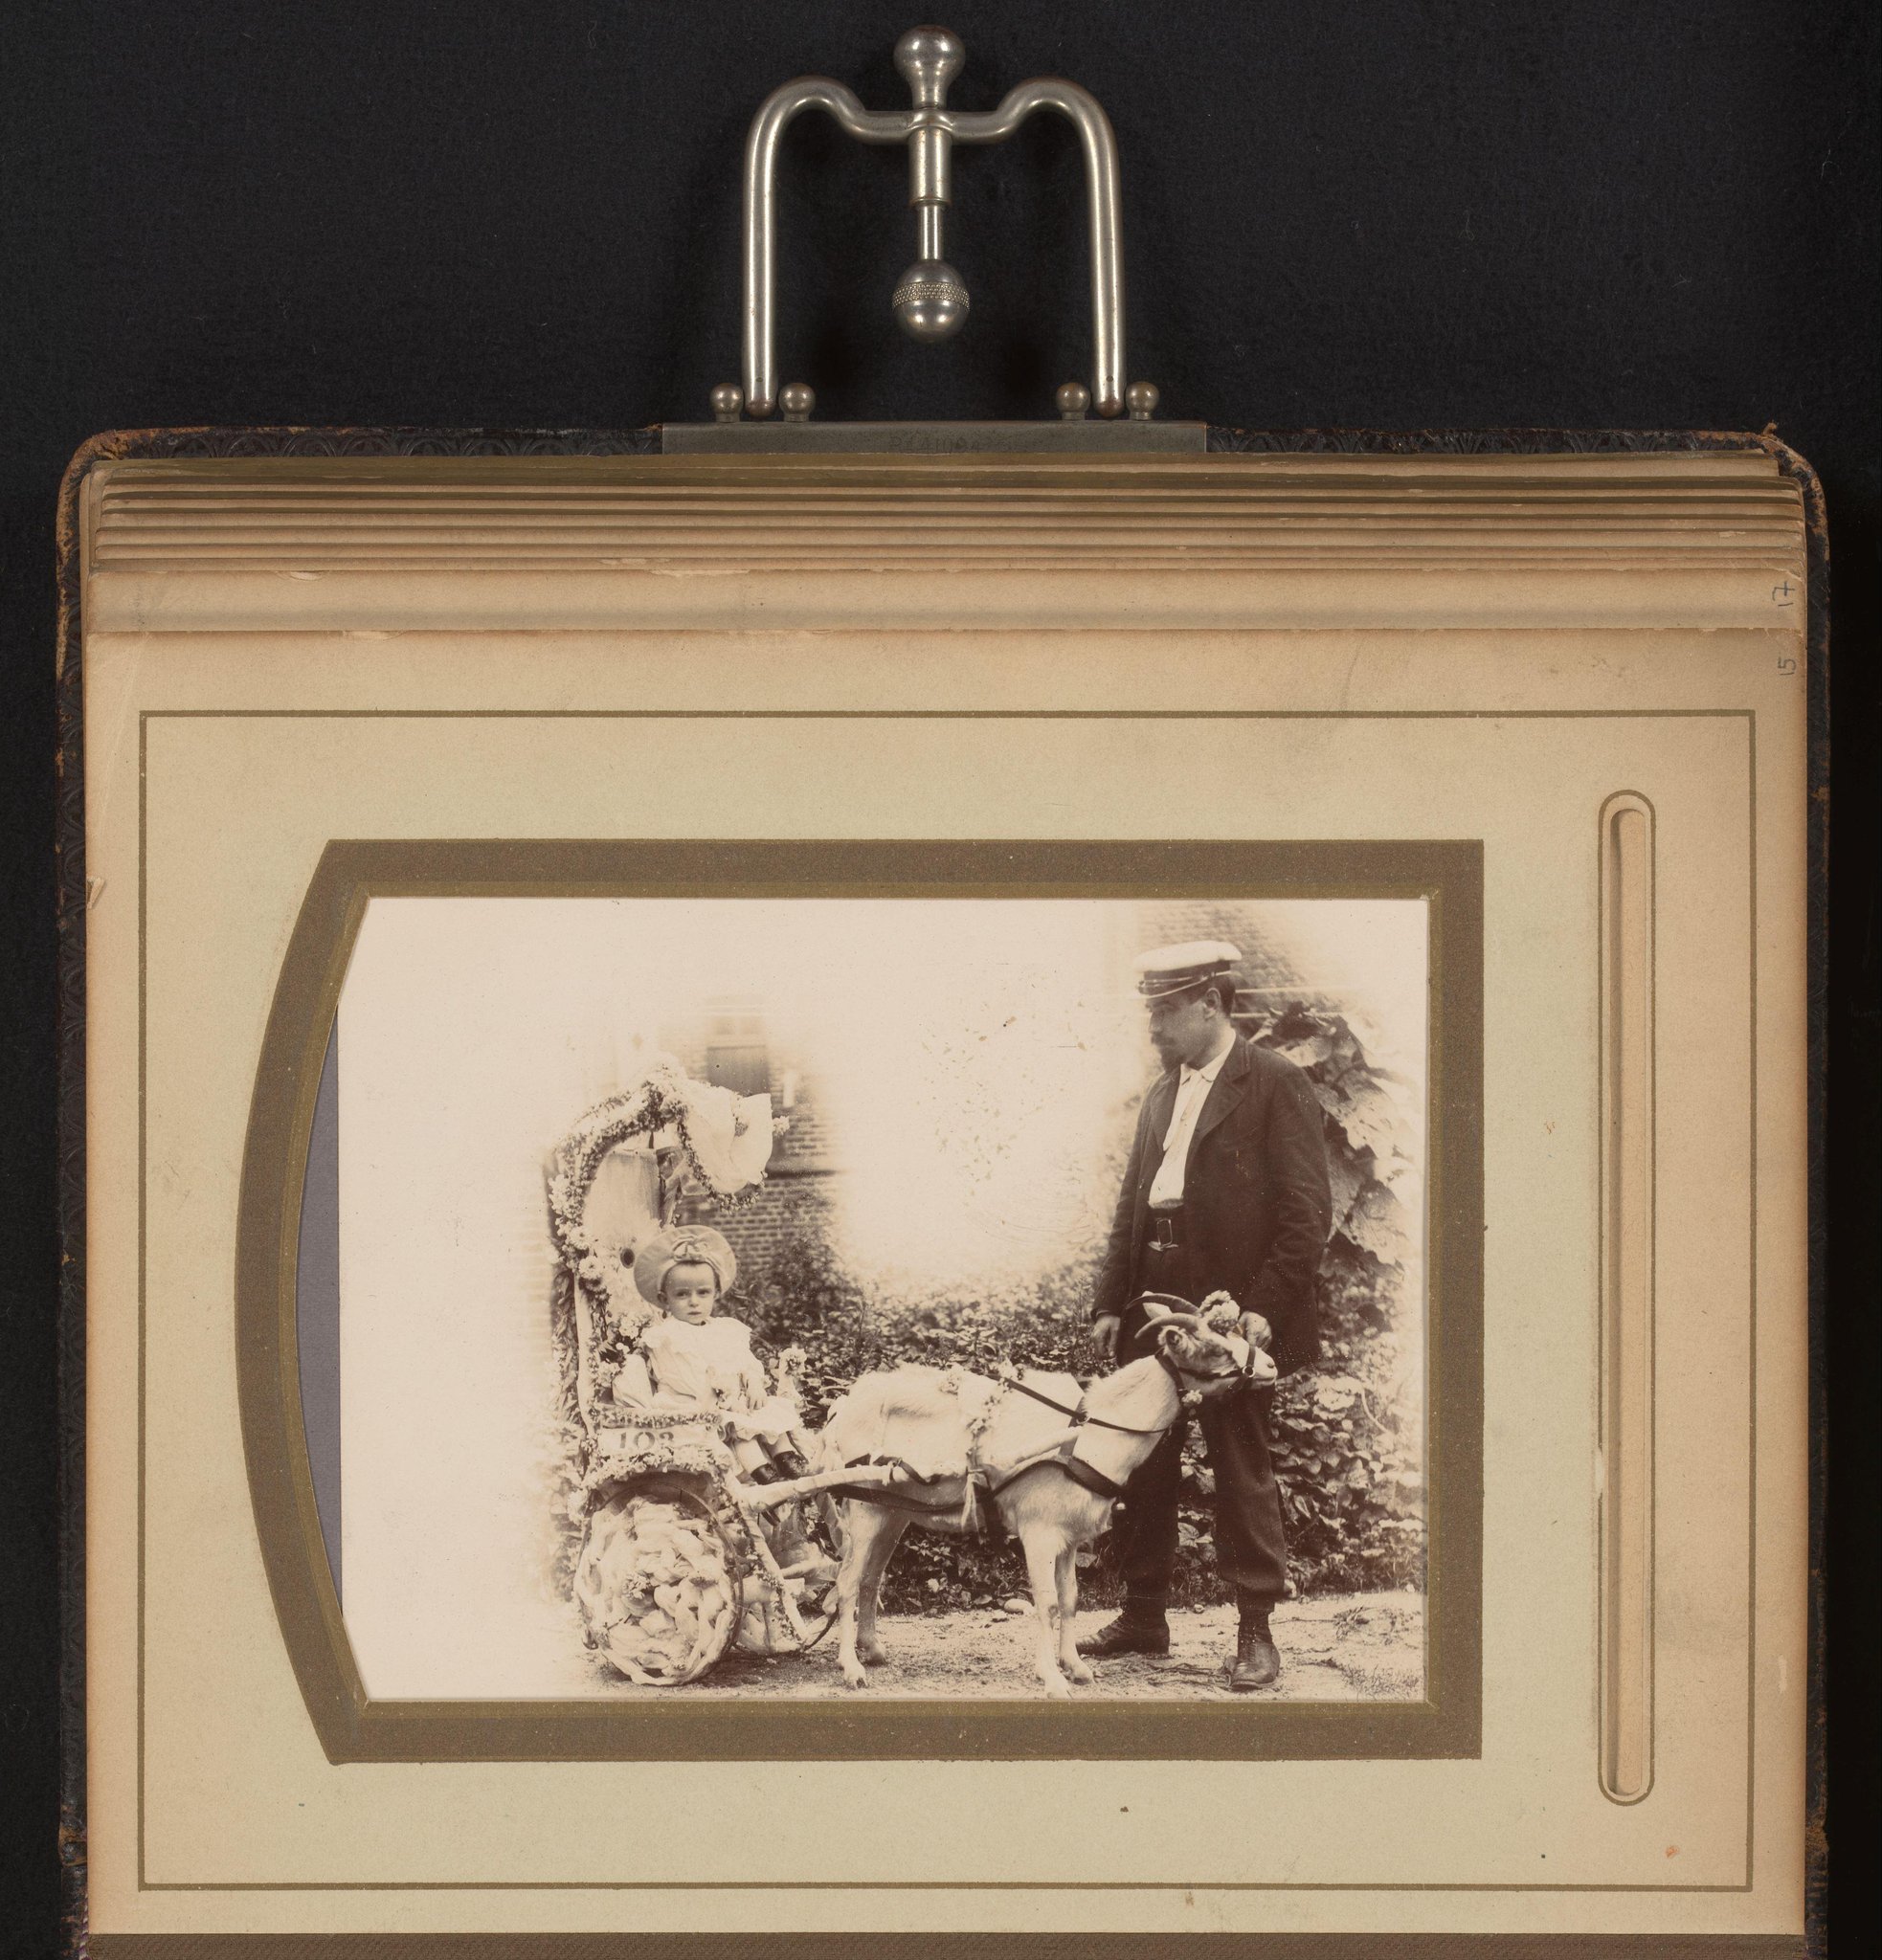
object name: cabinet photograph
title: Meisje in een wagen met een geit ervoor, begeleid door een man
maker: Anonymous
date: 1880-1940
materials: cardboard, photographic support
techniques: collodion silver print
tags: adult man, toddler (female), goat, two-wheeled vehicle drawn by one animal